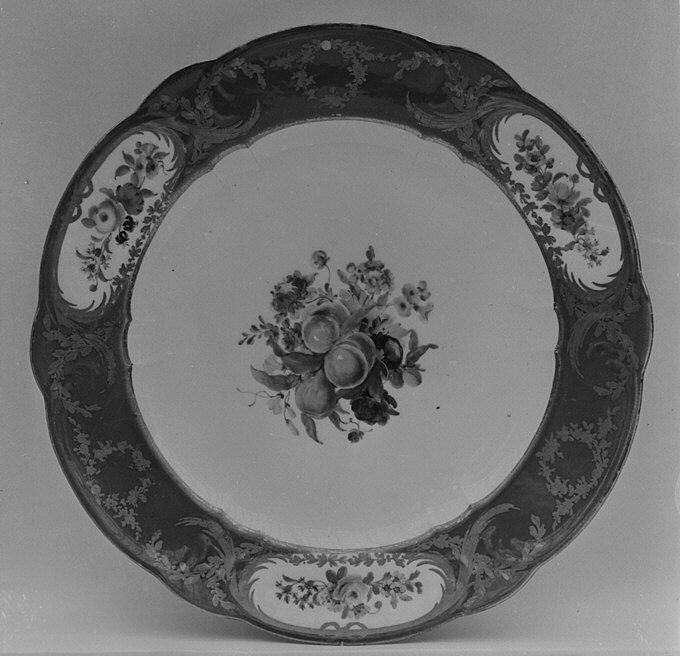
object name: plate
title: Plate (part of a service)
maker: sèvres manufactory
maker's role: manufactory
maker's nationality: french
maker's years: 1740-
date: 1784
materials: soft paste porcelain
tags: fruit,flowers